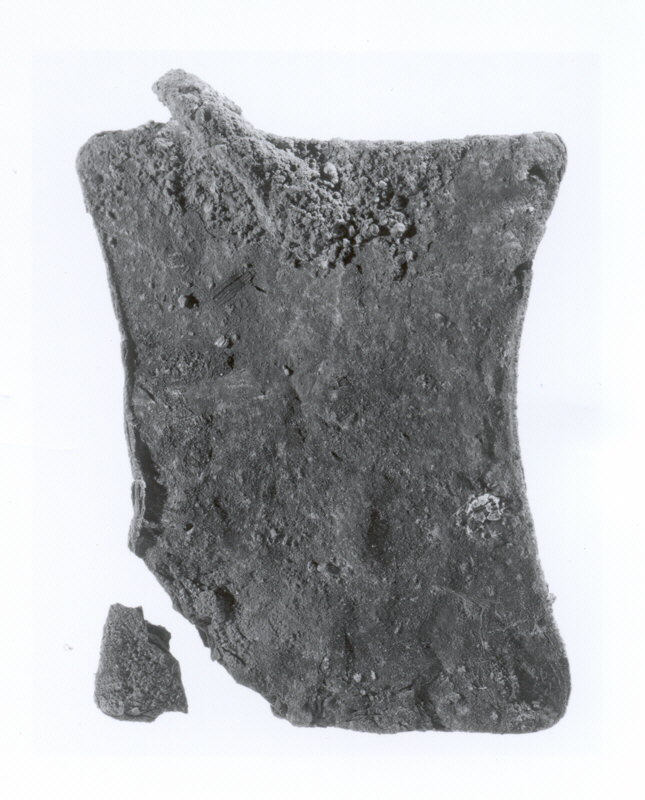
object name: harness or bridle ornament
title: Harness or bridle ornament (?)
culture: iranian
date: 900-801 BCE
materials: bronze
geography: iran